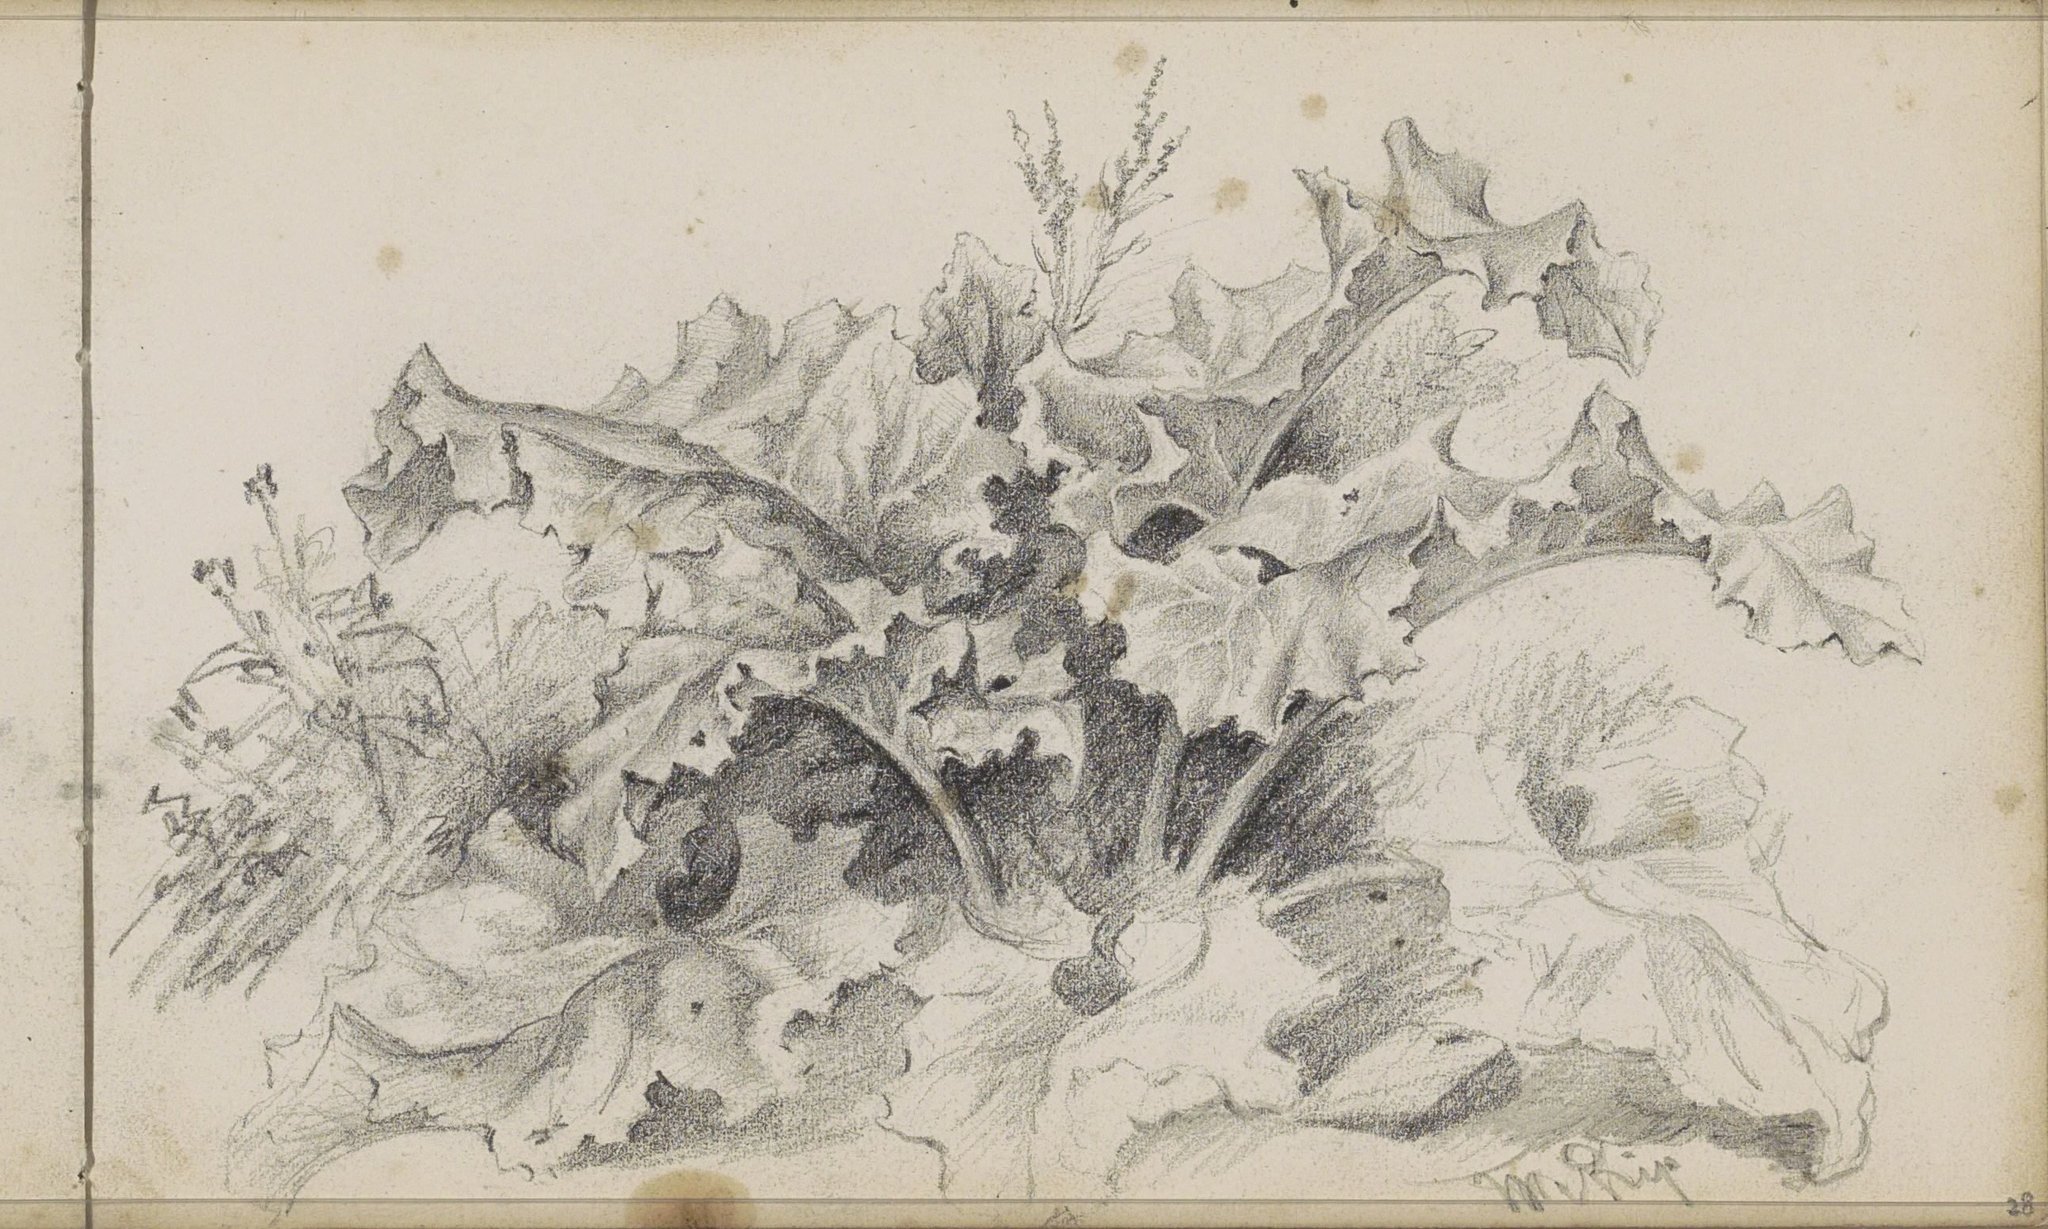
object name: sketchbook leaf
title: Bermplanten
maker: willem cornelis rip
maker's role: draughtsman, painter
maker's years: 1856-1922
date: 1874-1875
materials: paper, pencil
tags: plants (in general)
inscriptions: signature: ‘Wc Rip’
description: Blad 28 recto uit een schetsboek met 46 bladen.